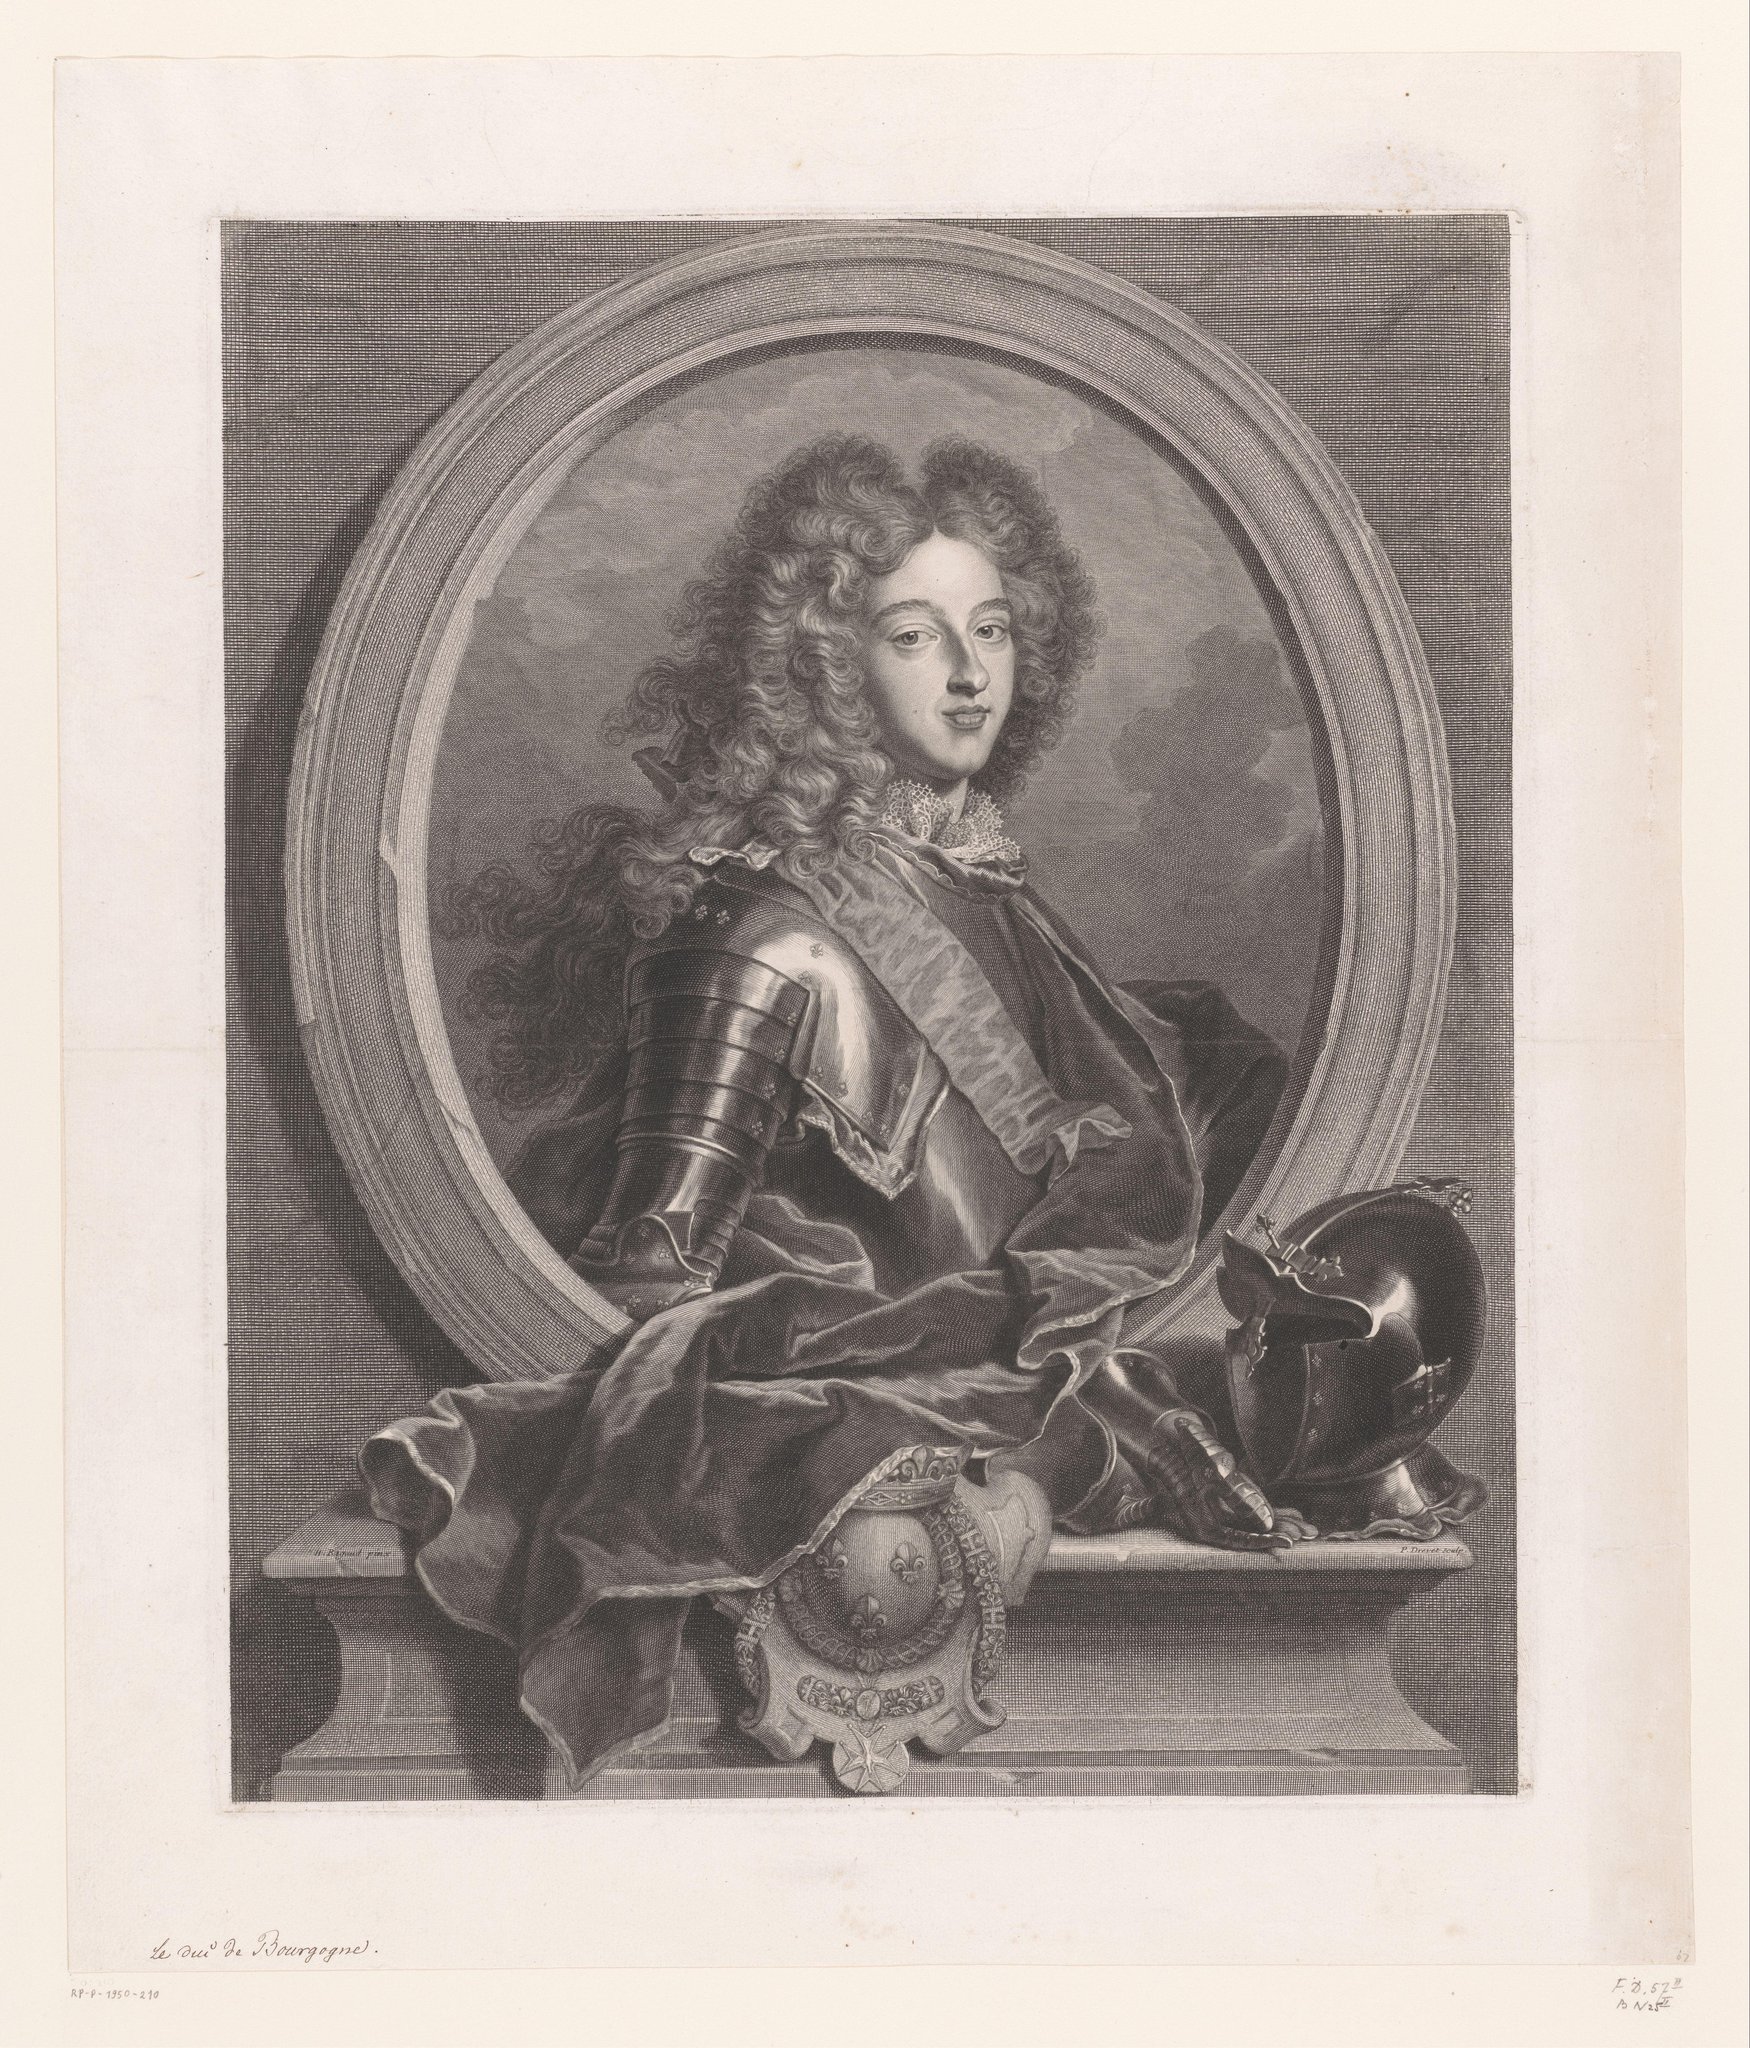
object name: print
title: Portret van Lodewijk van Frankrijk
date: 1707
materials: paper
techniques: engraving, etching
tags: lodewijk van frankrijk (hertog van bourgondië), historical persons, king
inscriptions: inscription: ‘Le Duc de Bourgogne’